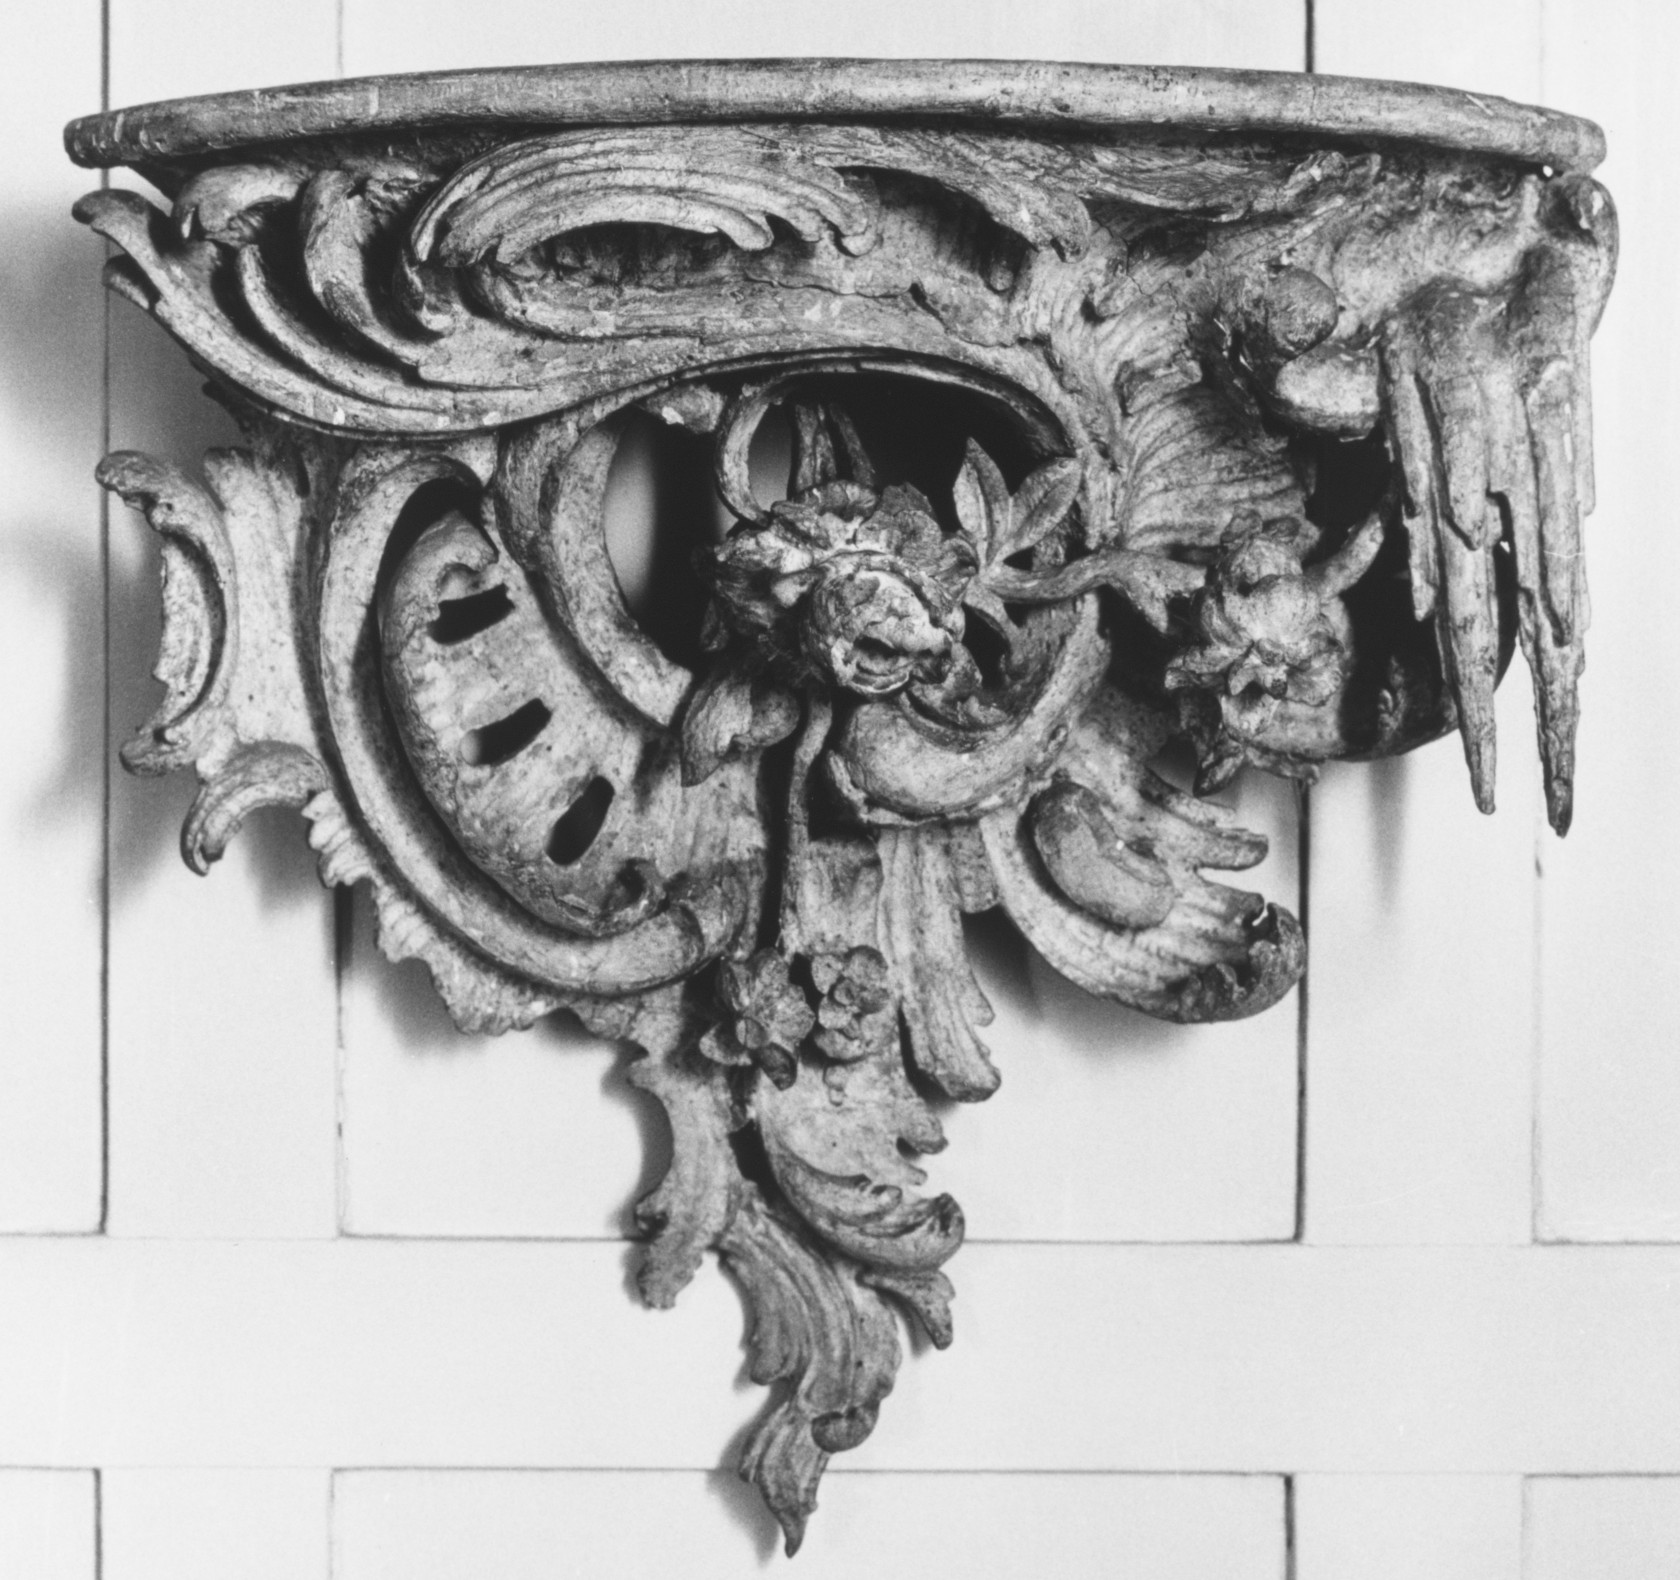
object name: wall bracket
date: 1745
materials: wood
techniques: carving, painting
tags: flowers